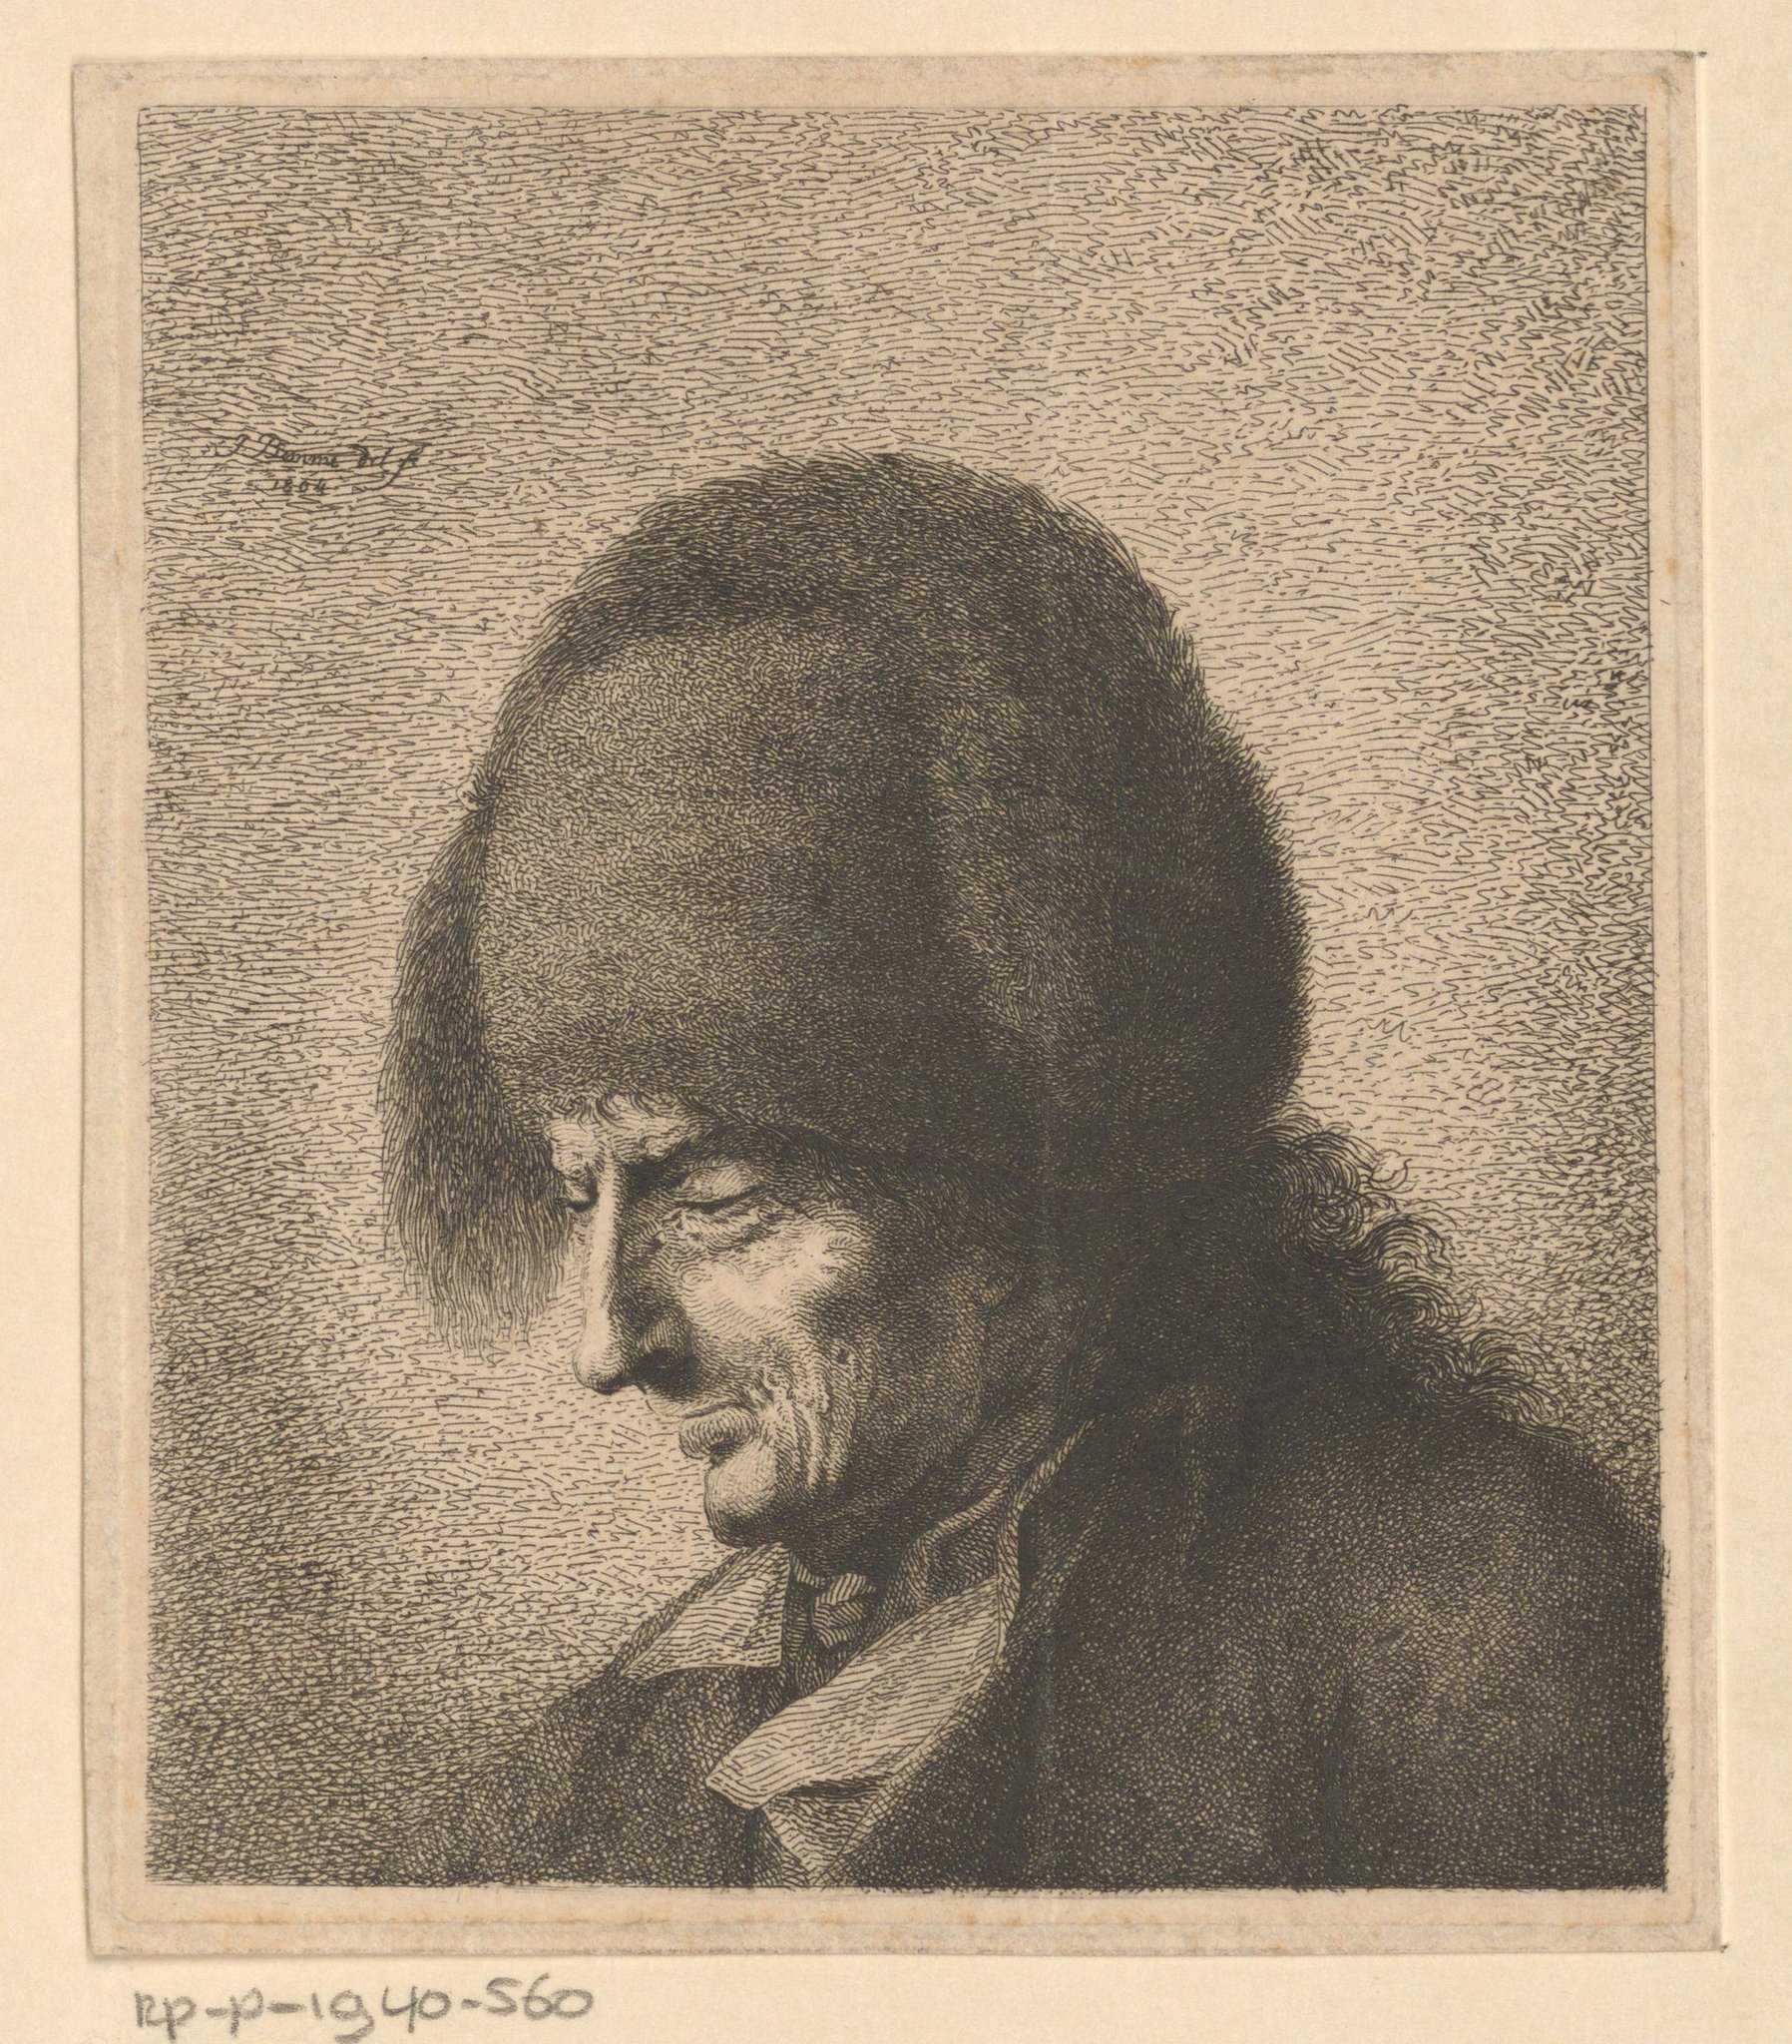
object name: print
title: Portret van een onbekende man met bontmuts, mogelijk genaamd Van der Werff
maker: joannes bemme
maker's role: print maker, printer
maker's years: 1775-1841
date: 1804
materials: paper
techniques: etching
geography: rotterdam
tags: head-gear: cap (+ men's clothes), old man, historical persons not known by name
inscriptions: collector's mark: Lugt 2228, collector's mark: Lugt 2760, inscription: ‘De beeldhouwer vd. Werff?’